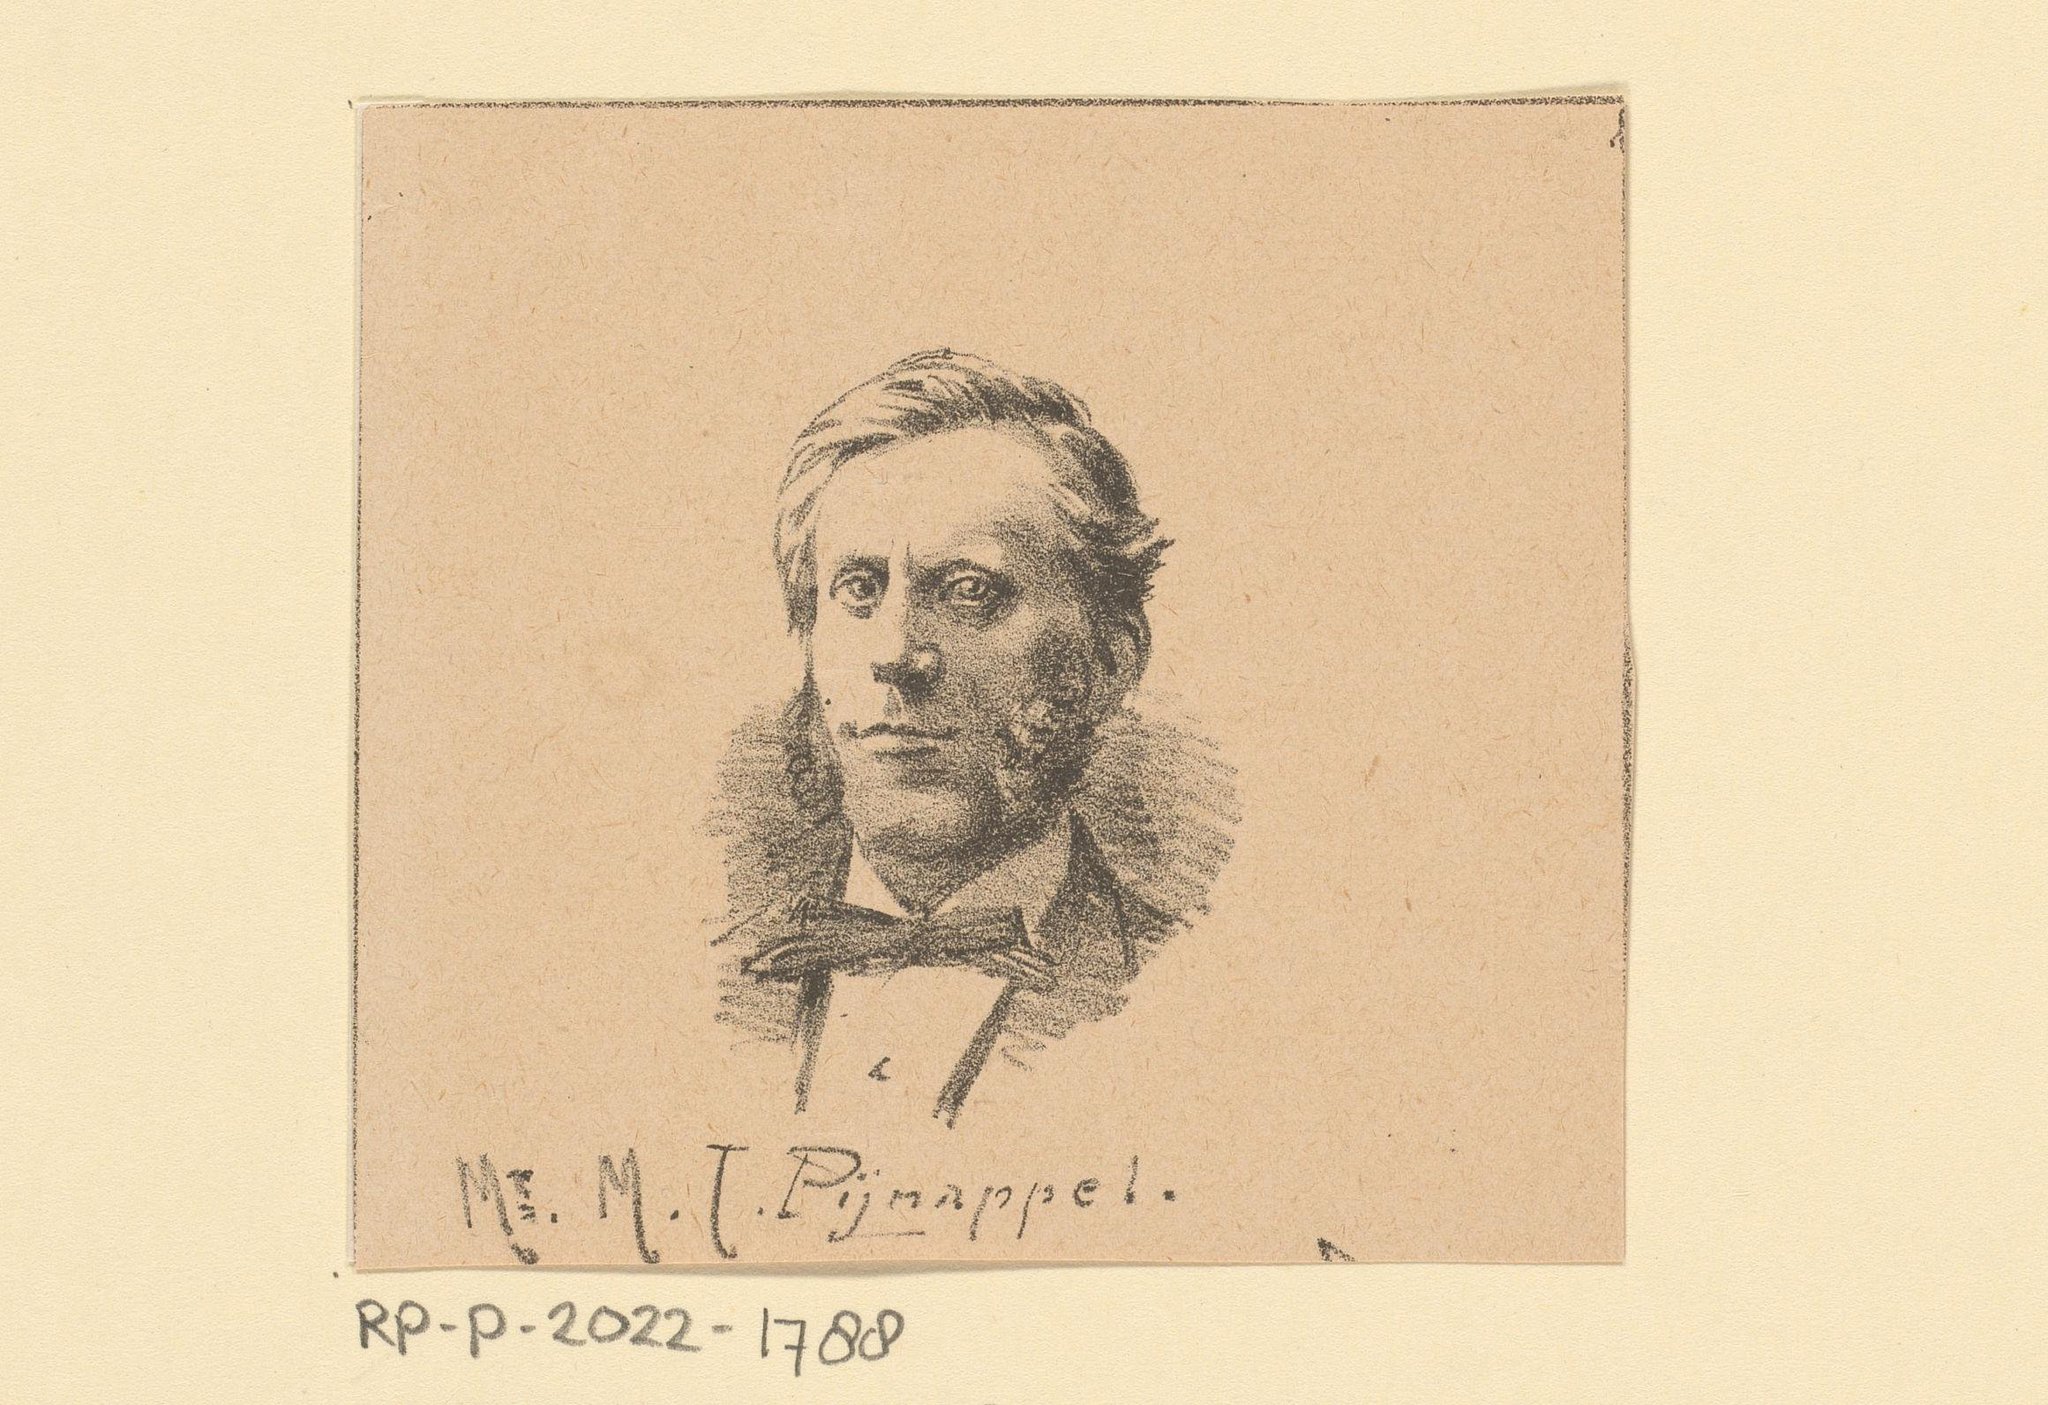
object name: print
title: Portret van Menso Johannes Pijnappel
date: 1886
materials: paper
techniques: lithograph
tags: politician, historical persons, politician, e.g. party leader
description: Prent mogelijk uit: De Amsterdammer, weekblad voor Nederland (1886), 31 oktober 1886.